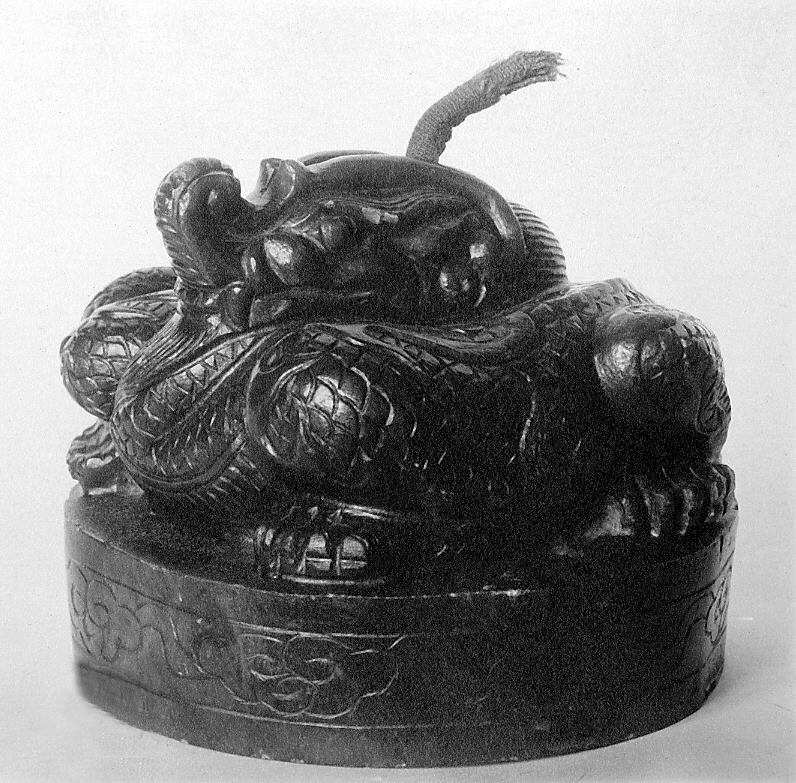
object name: seal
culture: chinese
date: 1368-1644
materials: jade